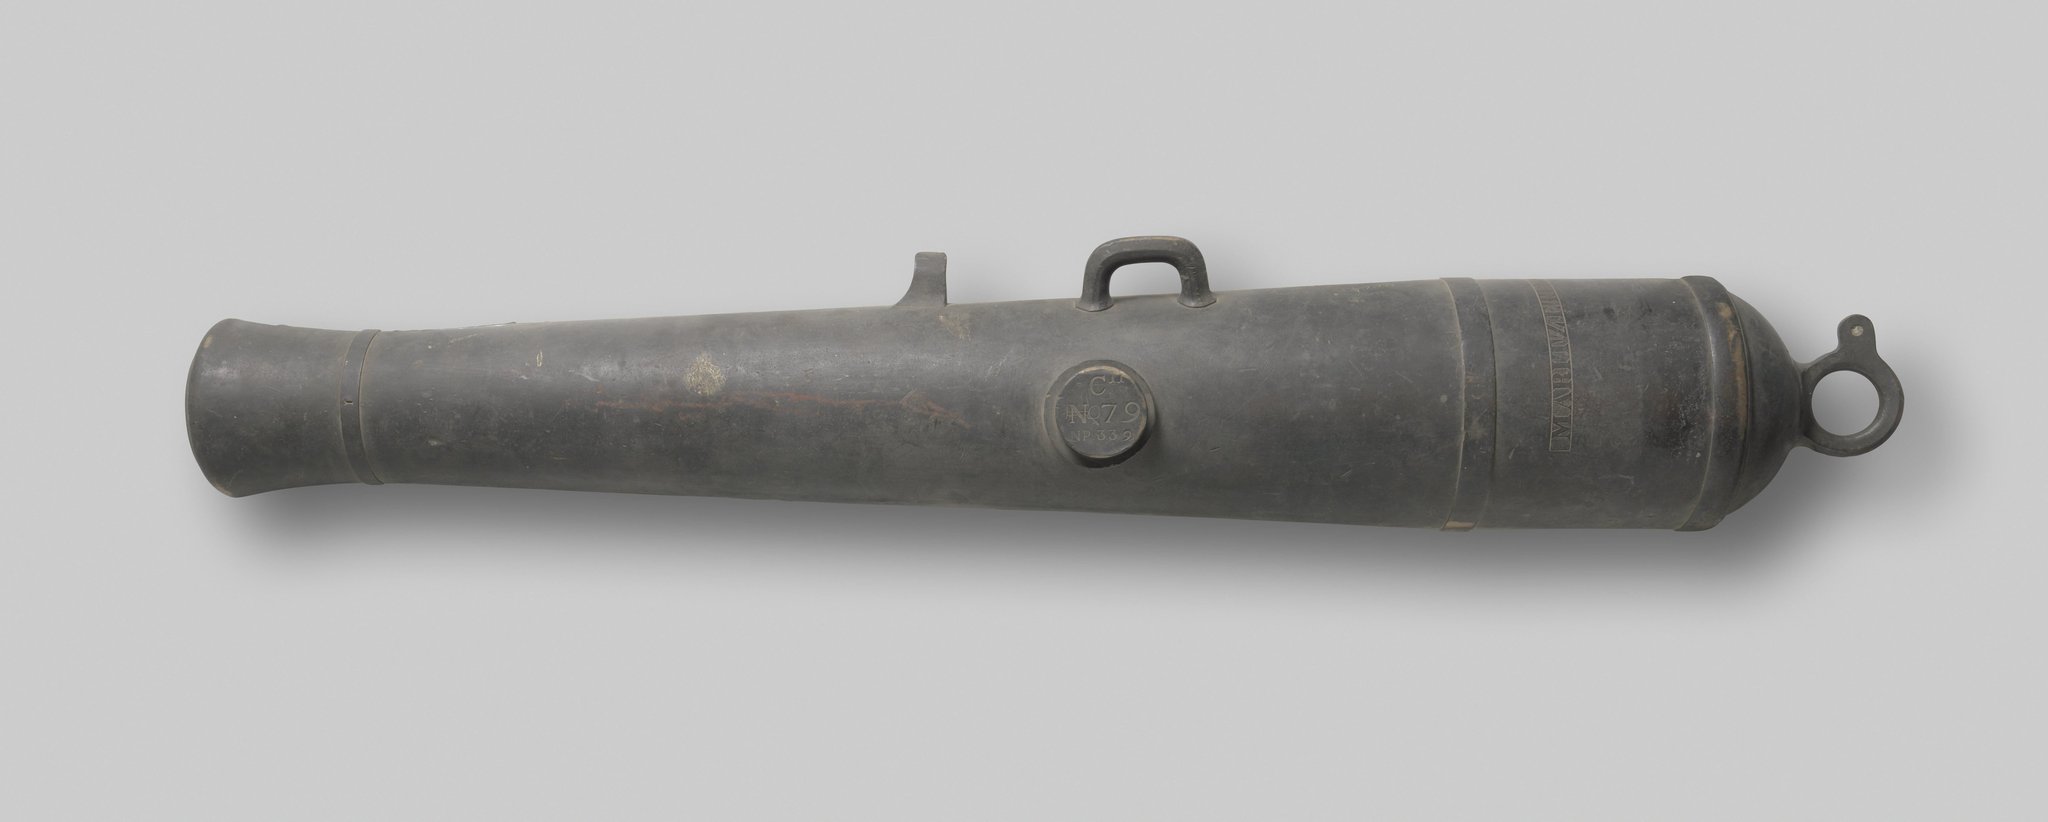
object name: cannon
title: Bronzen voorlaadkanon, deel rechtsvoor?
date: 1845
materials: bronze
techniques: casting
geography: the hague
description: Bronzen voorlaadkanon van 339 NP in drie stukken. Opschrift: MARITZ ET FILEC HAGAE, 1845. Volgegoten en in 3 stukken gesneden.